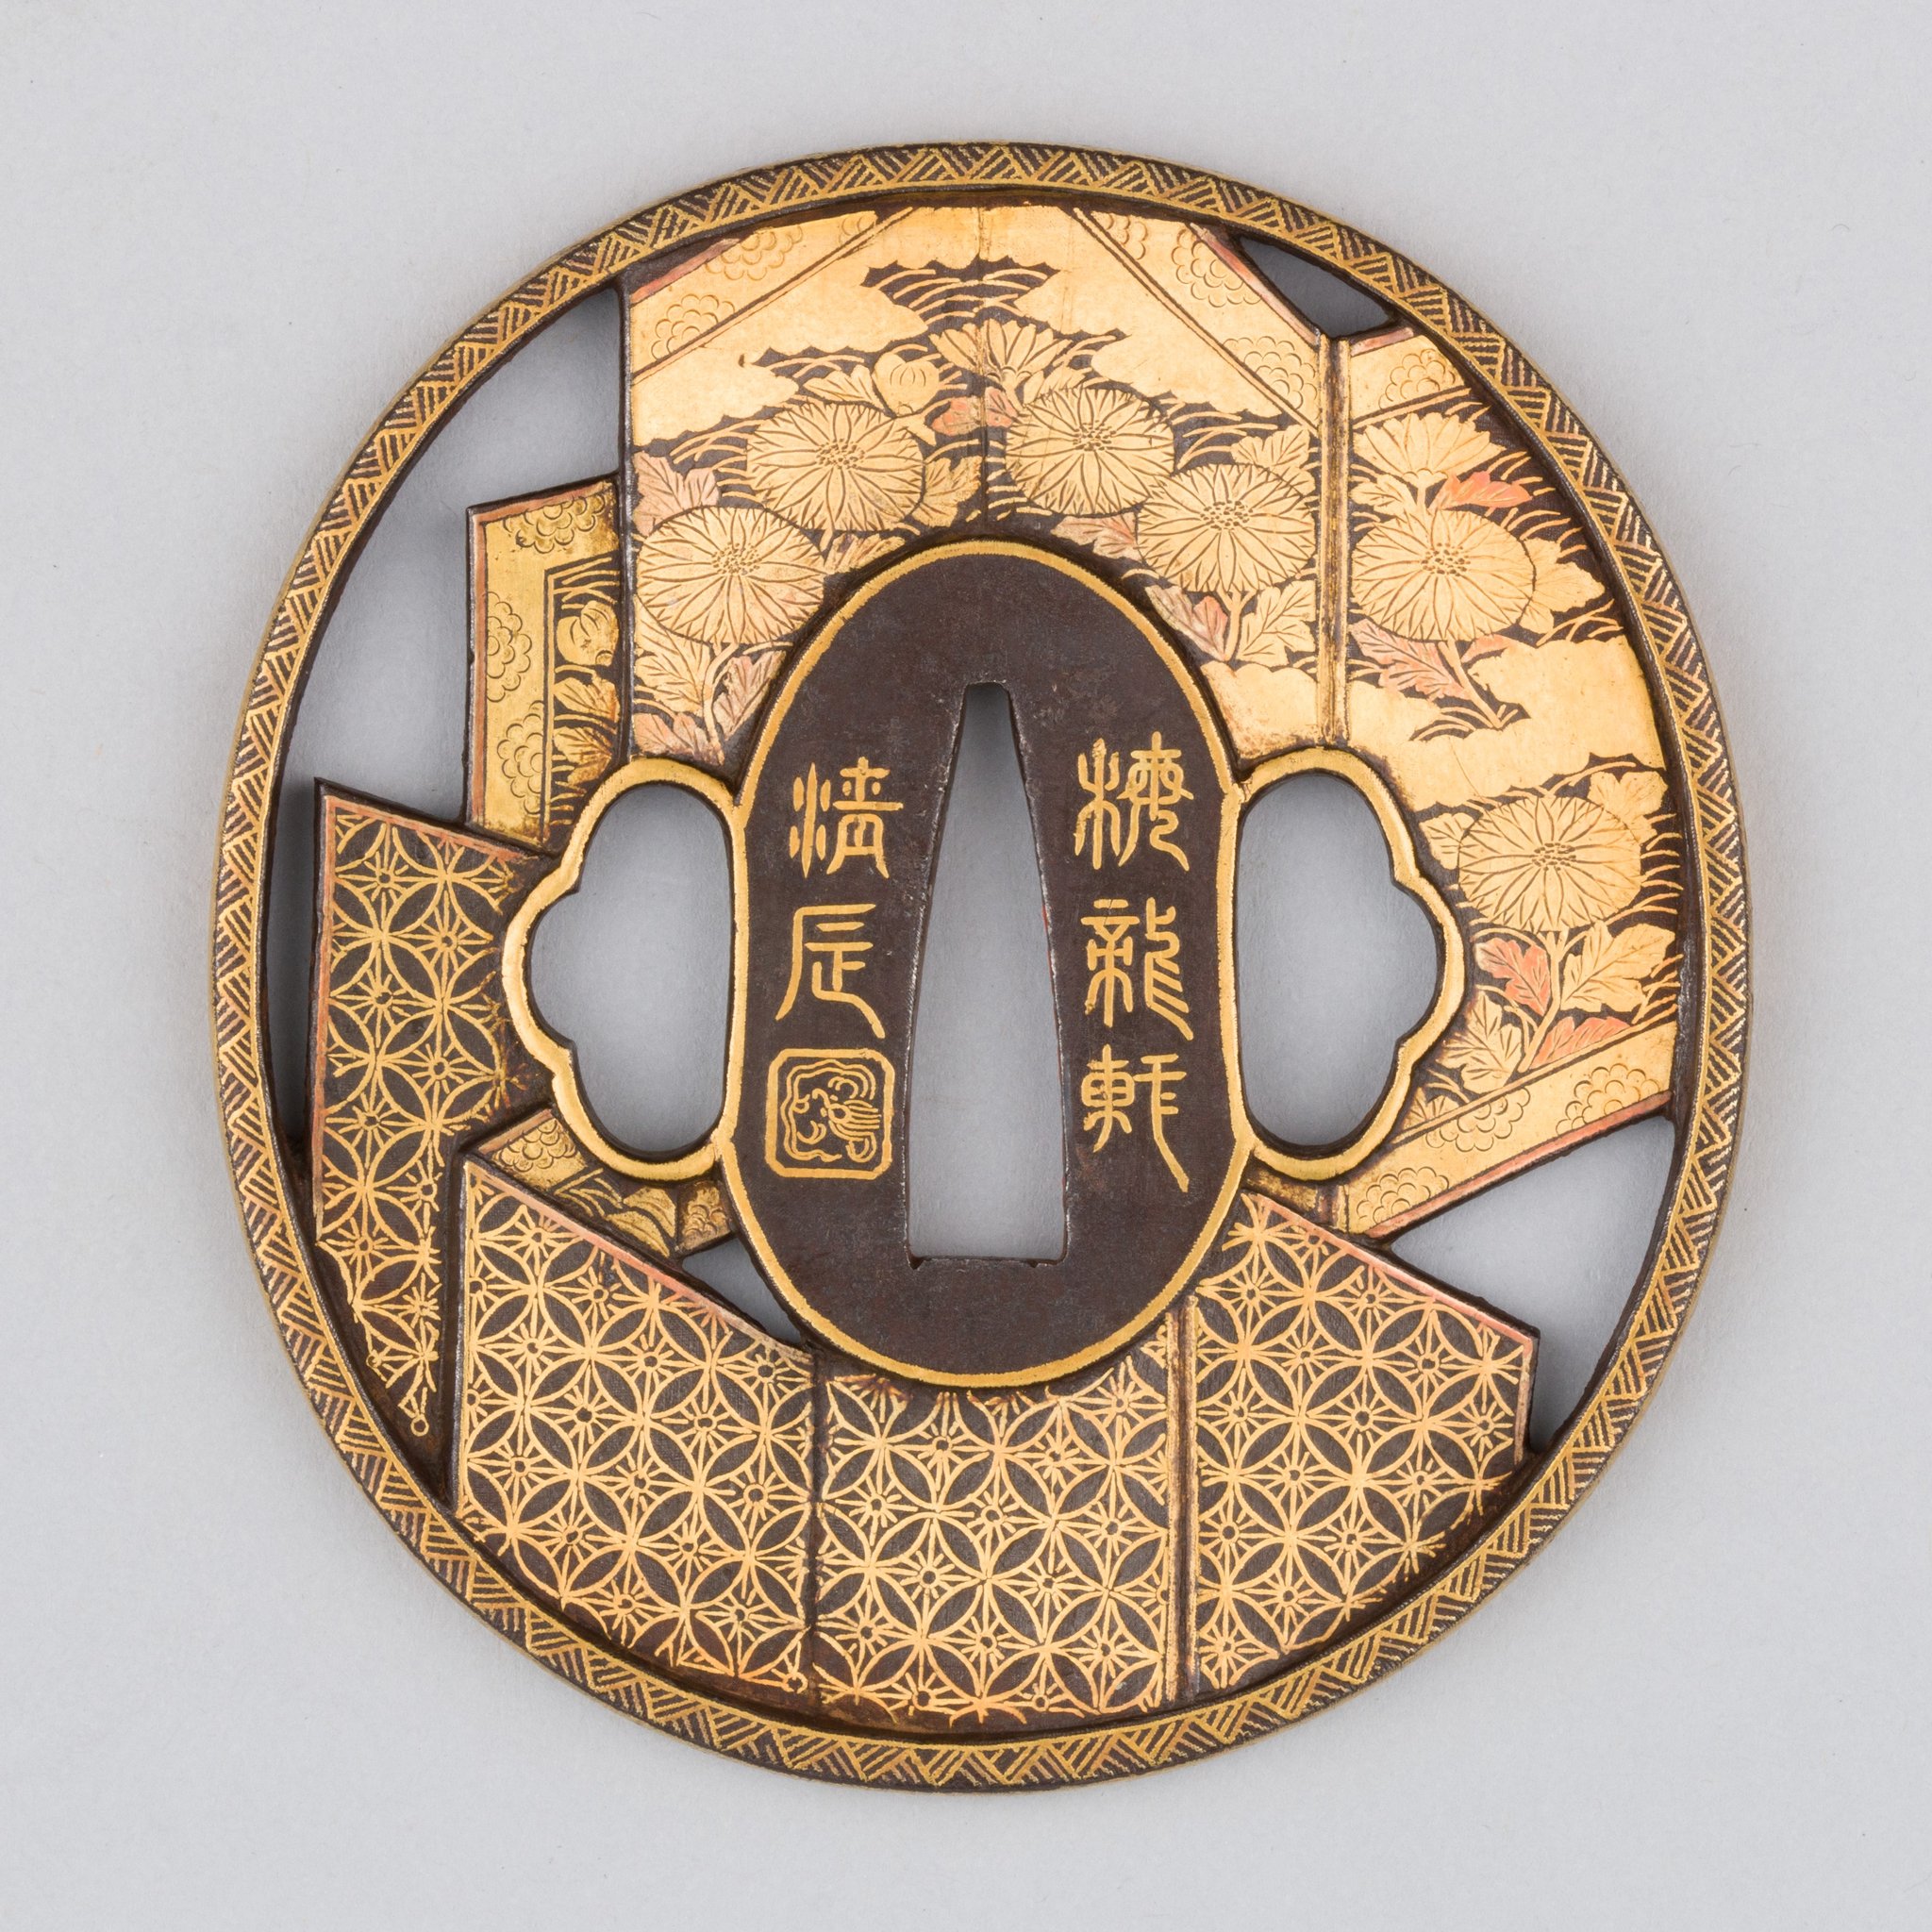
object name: sword guard tsuba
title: Sword Guard (Tsuba)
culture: japanese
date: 1701-1800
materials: copper, gold, iron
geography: japan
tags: flowers